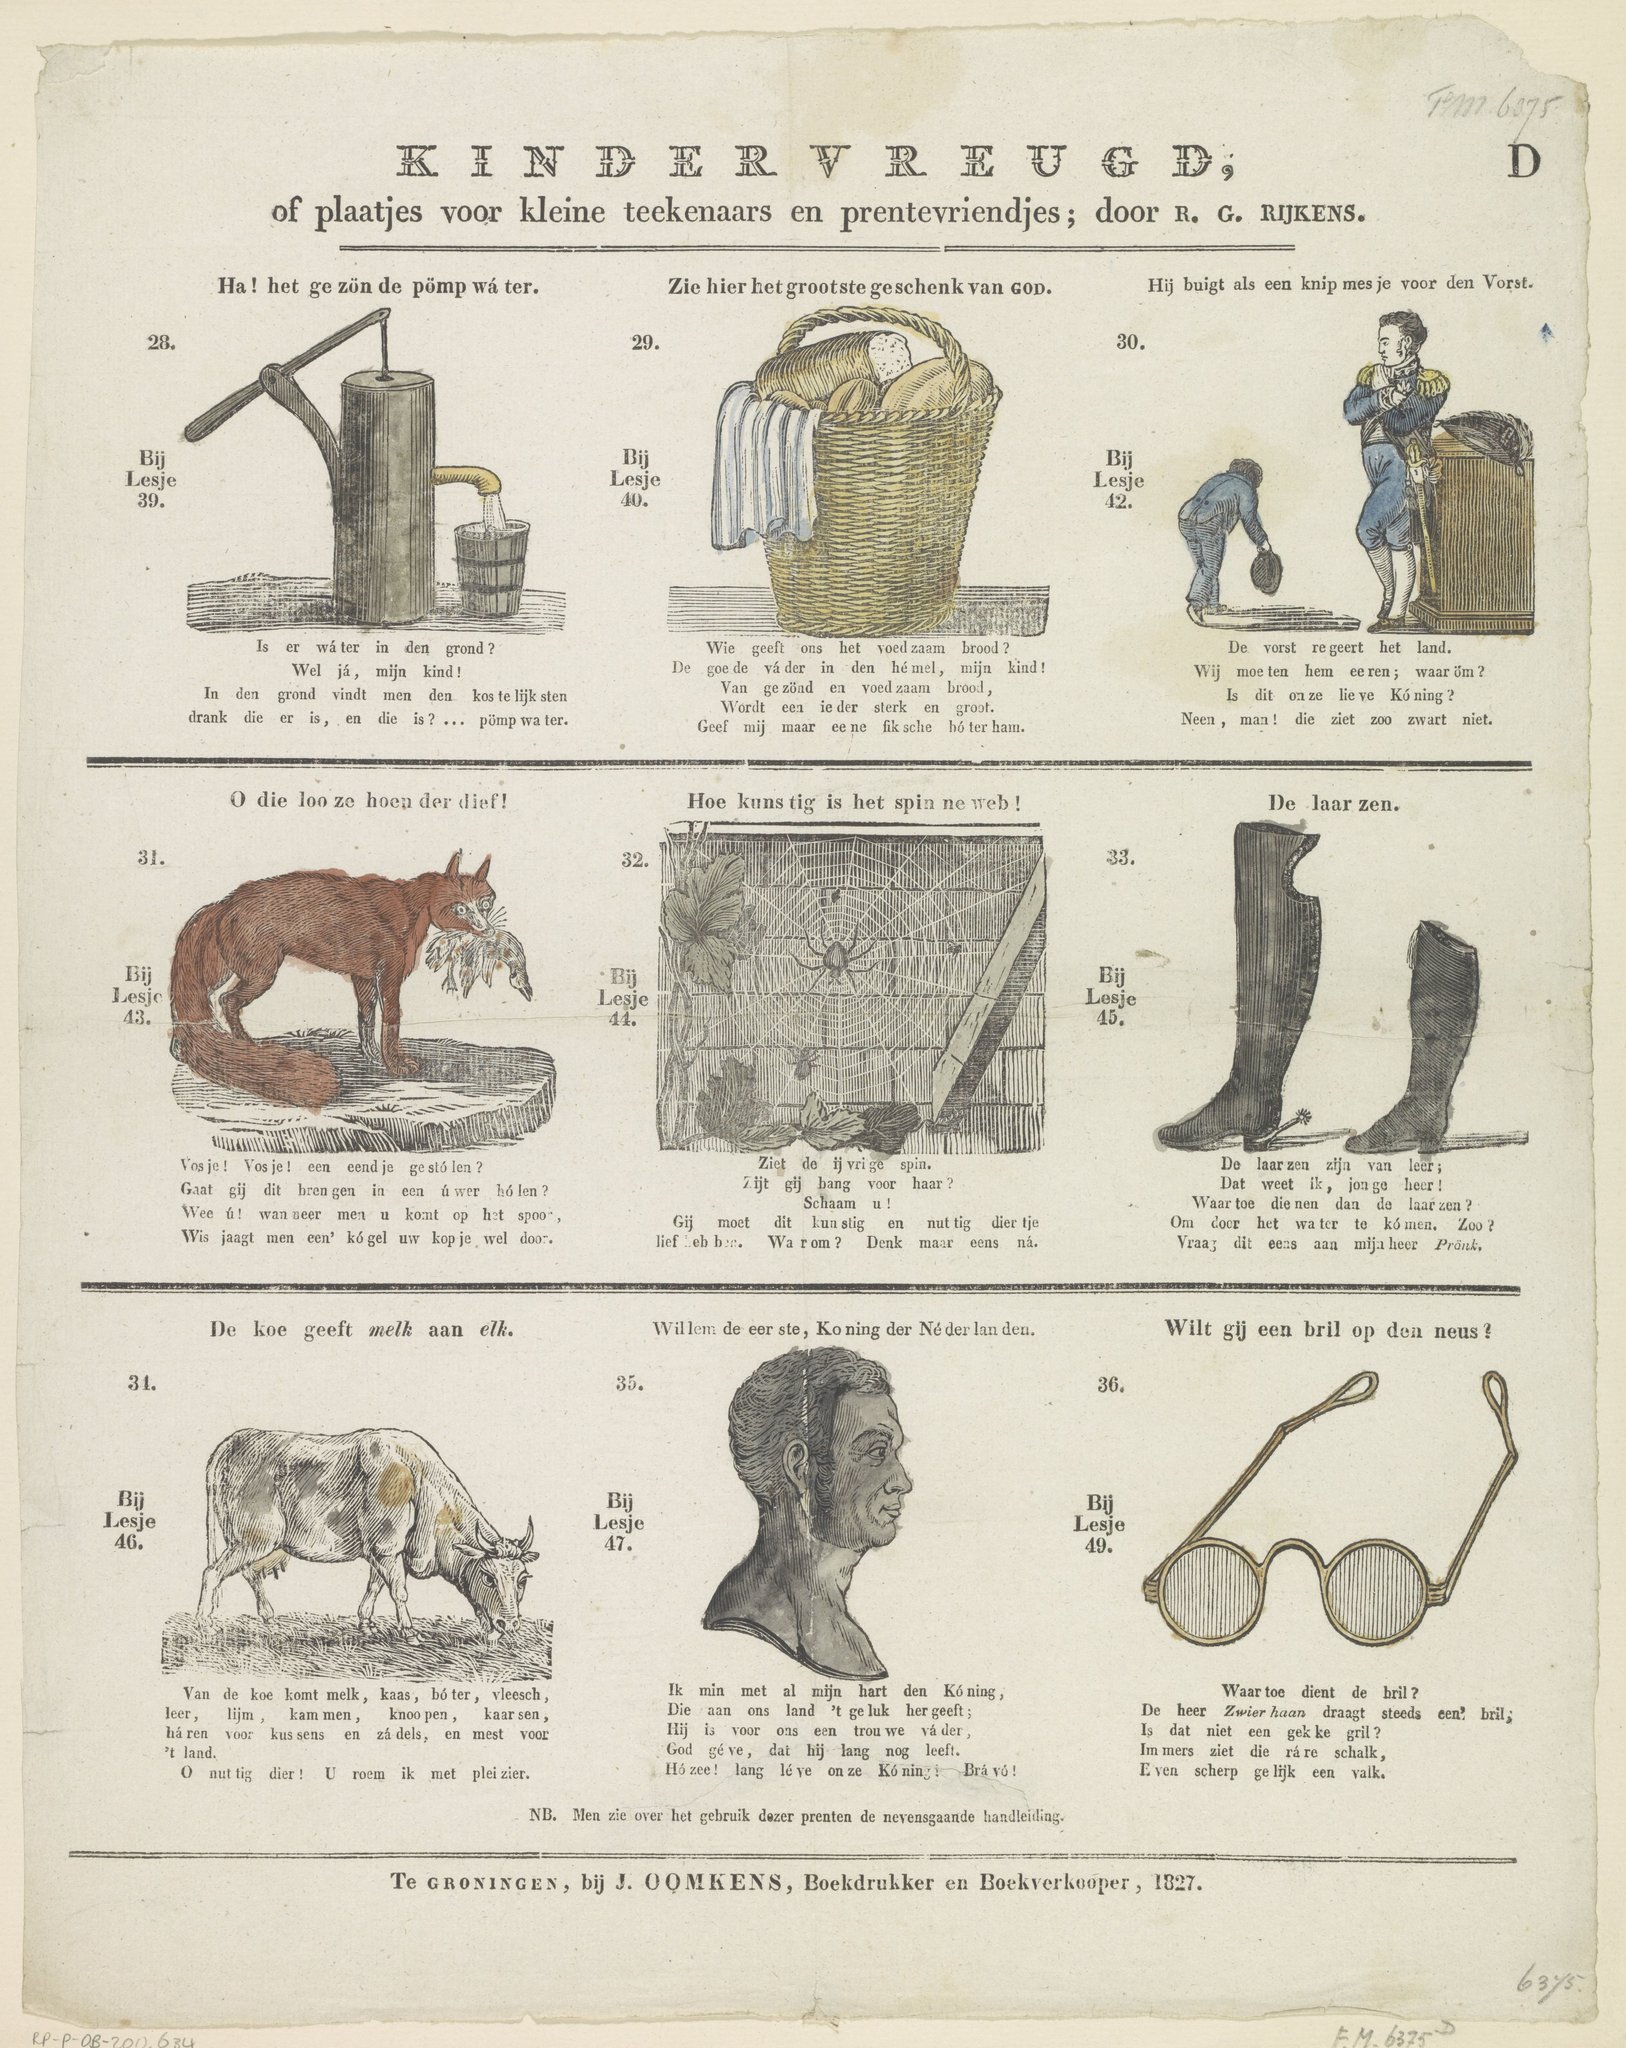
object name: popular print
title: Kindervreugd / of plaatjes voor kleine teekenaars en prentevriendjes; door R. G. Rijkens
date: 1827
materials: paper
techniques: colour, letterpress printing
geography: groningen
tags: the hague, william i of the netherlands, spiders, bread, cake, pastry, etc., pump, education, beasts of prey, predatory animals: fox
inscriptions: date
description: Blad met 9 illustraties (genummerd 28-36) bij leesboekjes van R.G. Rijkens. Elk plaatje hoort bij een lesje uit de boekjes "Natuurlijke Lees-Leerwijze". Weergegeven zijn ondermeer een waterpomp, een mand met brood, een vos, een spinnenweb en koning Willem I. Boven elke afbeelding een nummer en een titel en onder elke afbeelding een vierregelig vers. Links van elke afbeelding staat vermeld bij welke les het plaatje hoort. Gemerkt rechtsboven: D.